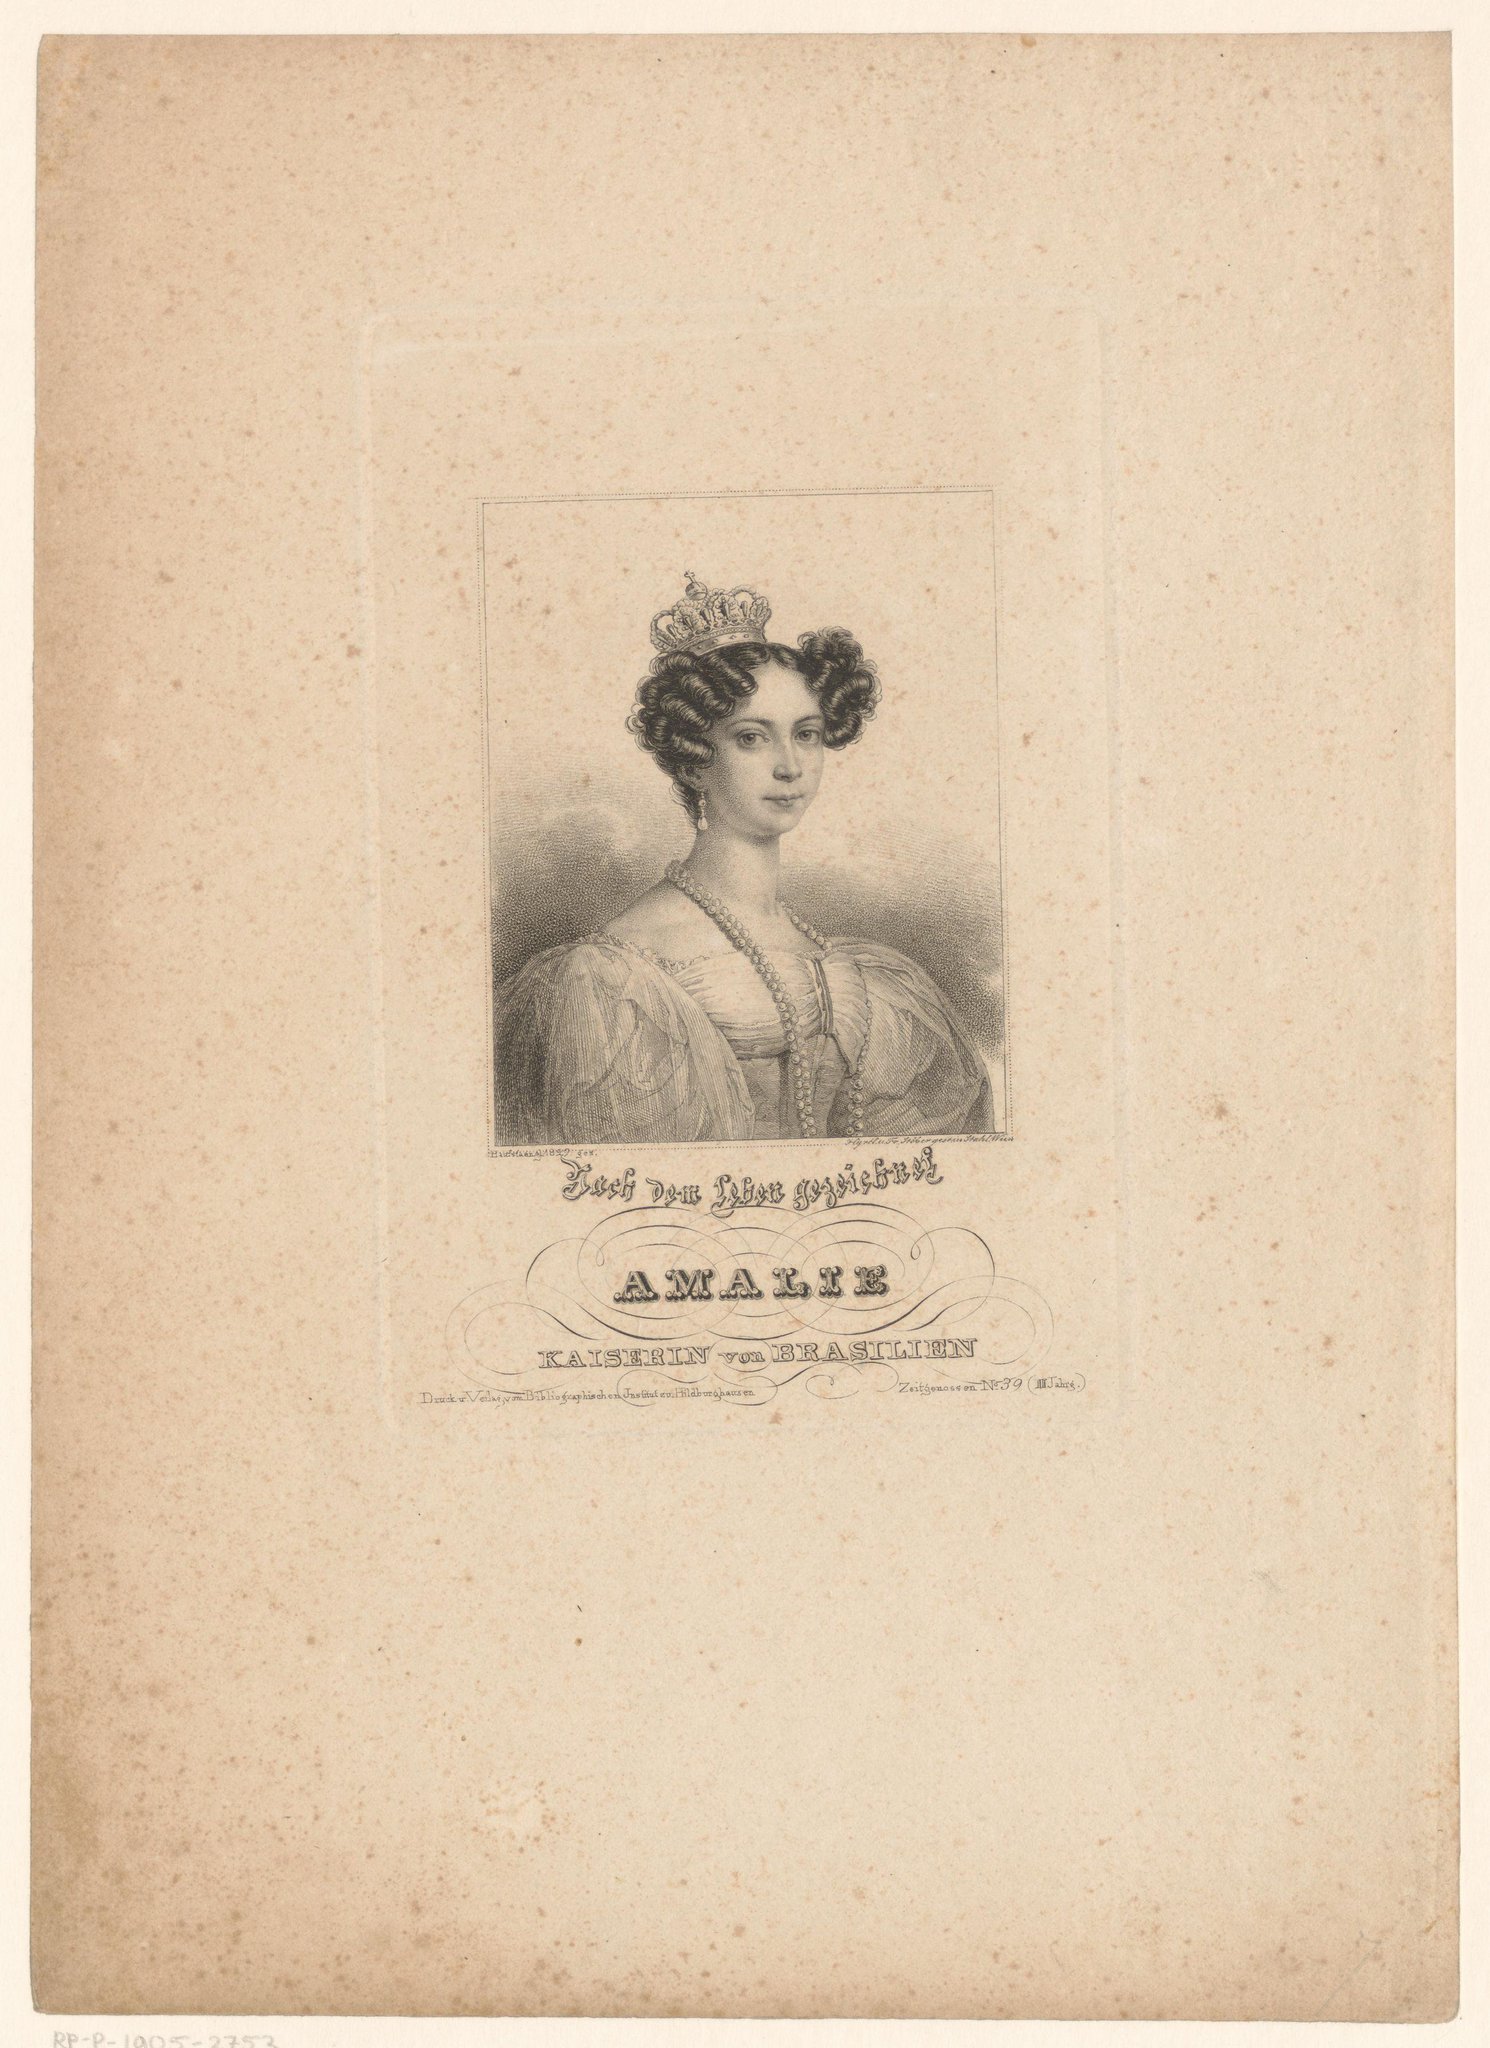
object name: print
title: Zeitgenossen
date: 1829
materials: paper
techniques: etching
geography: hildburghausen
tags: amélie van leuchtenberg (keizerin van brazilië), crown (symbol of sovereignty), historical persons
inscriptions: collector's mark: Lugt 2228